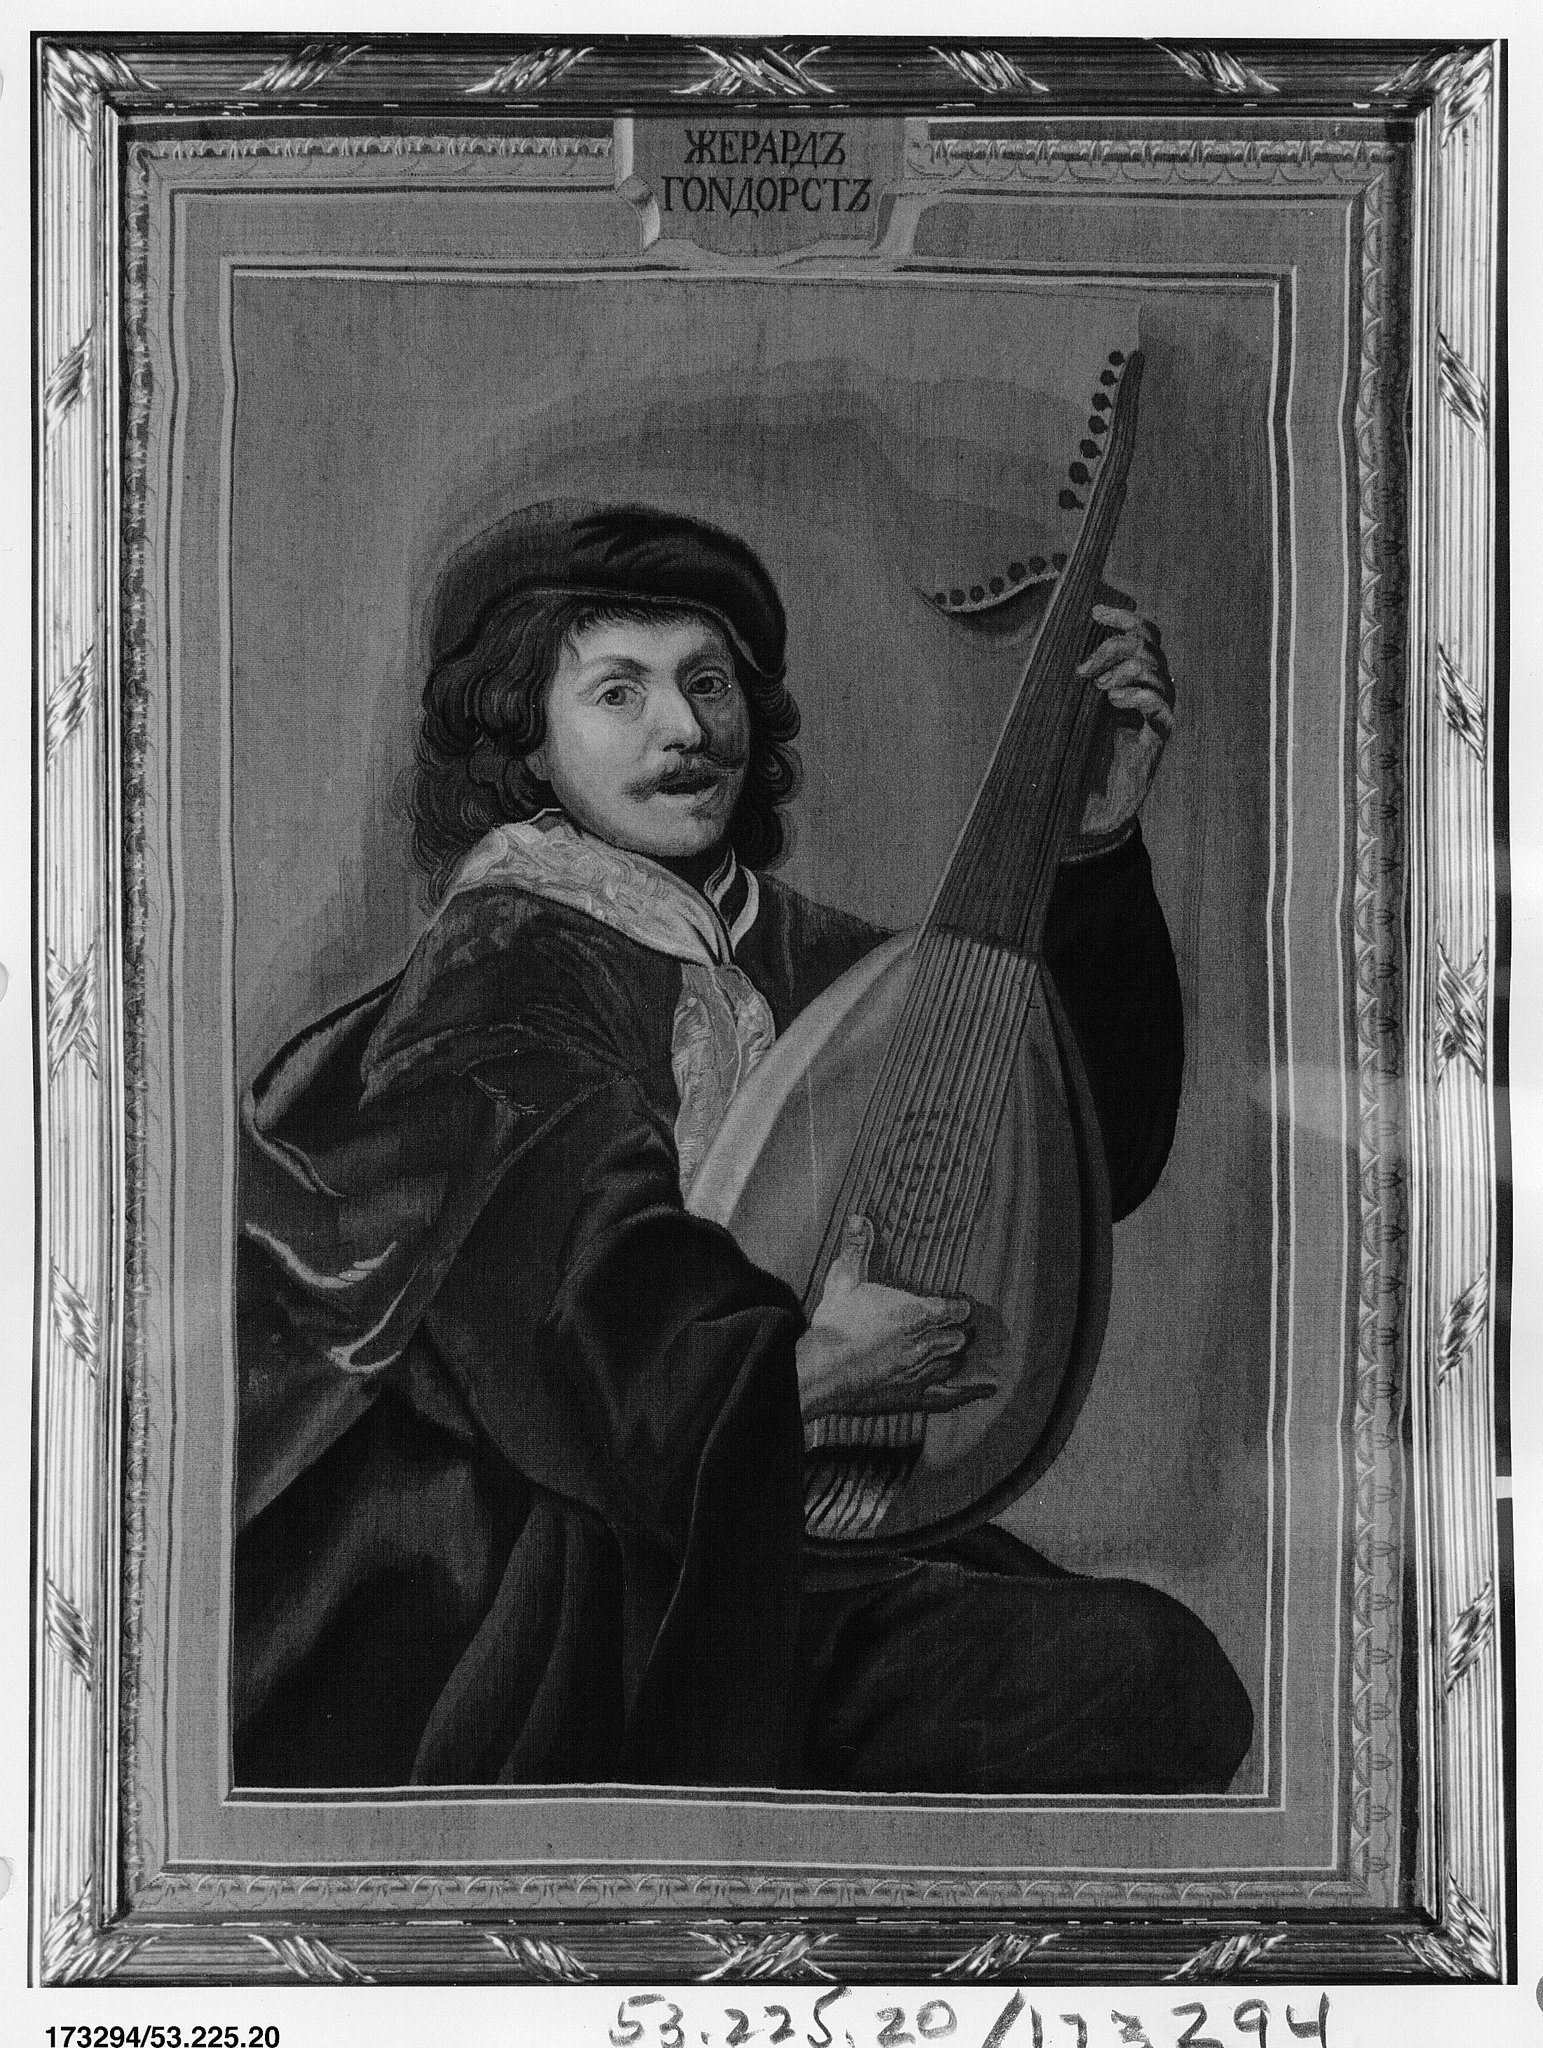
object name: tapestry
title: Man with a Lute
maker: imperial russian tapestry manufactory, saint petersburg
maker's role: manufactory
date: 1767-1800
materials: metal thread, wool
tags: men,portraits,music,lutes